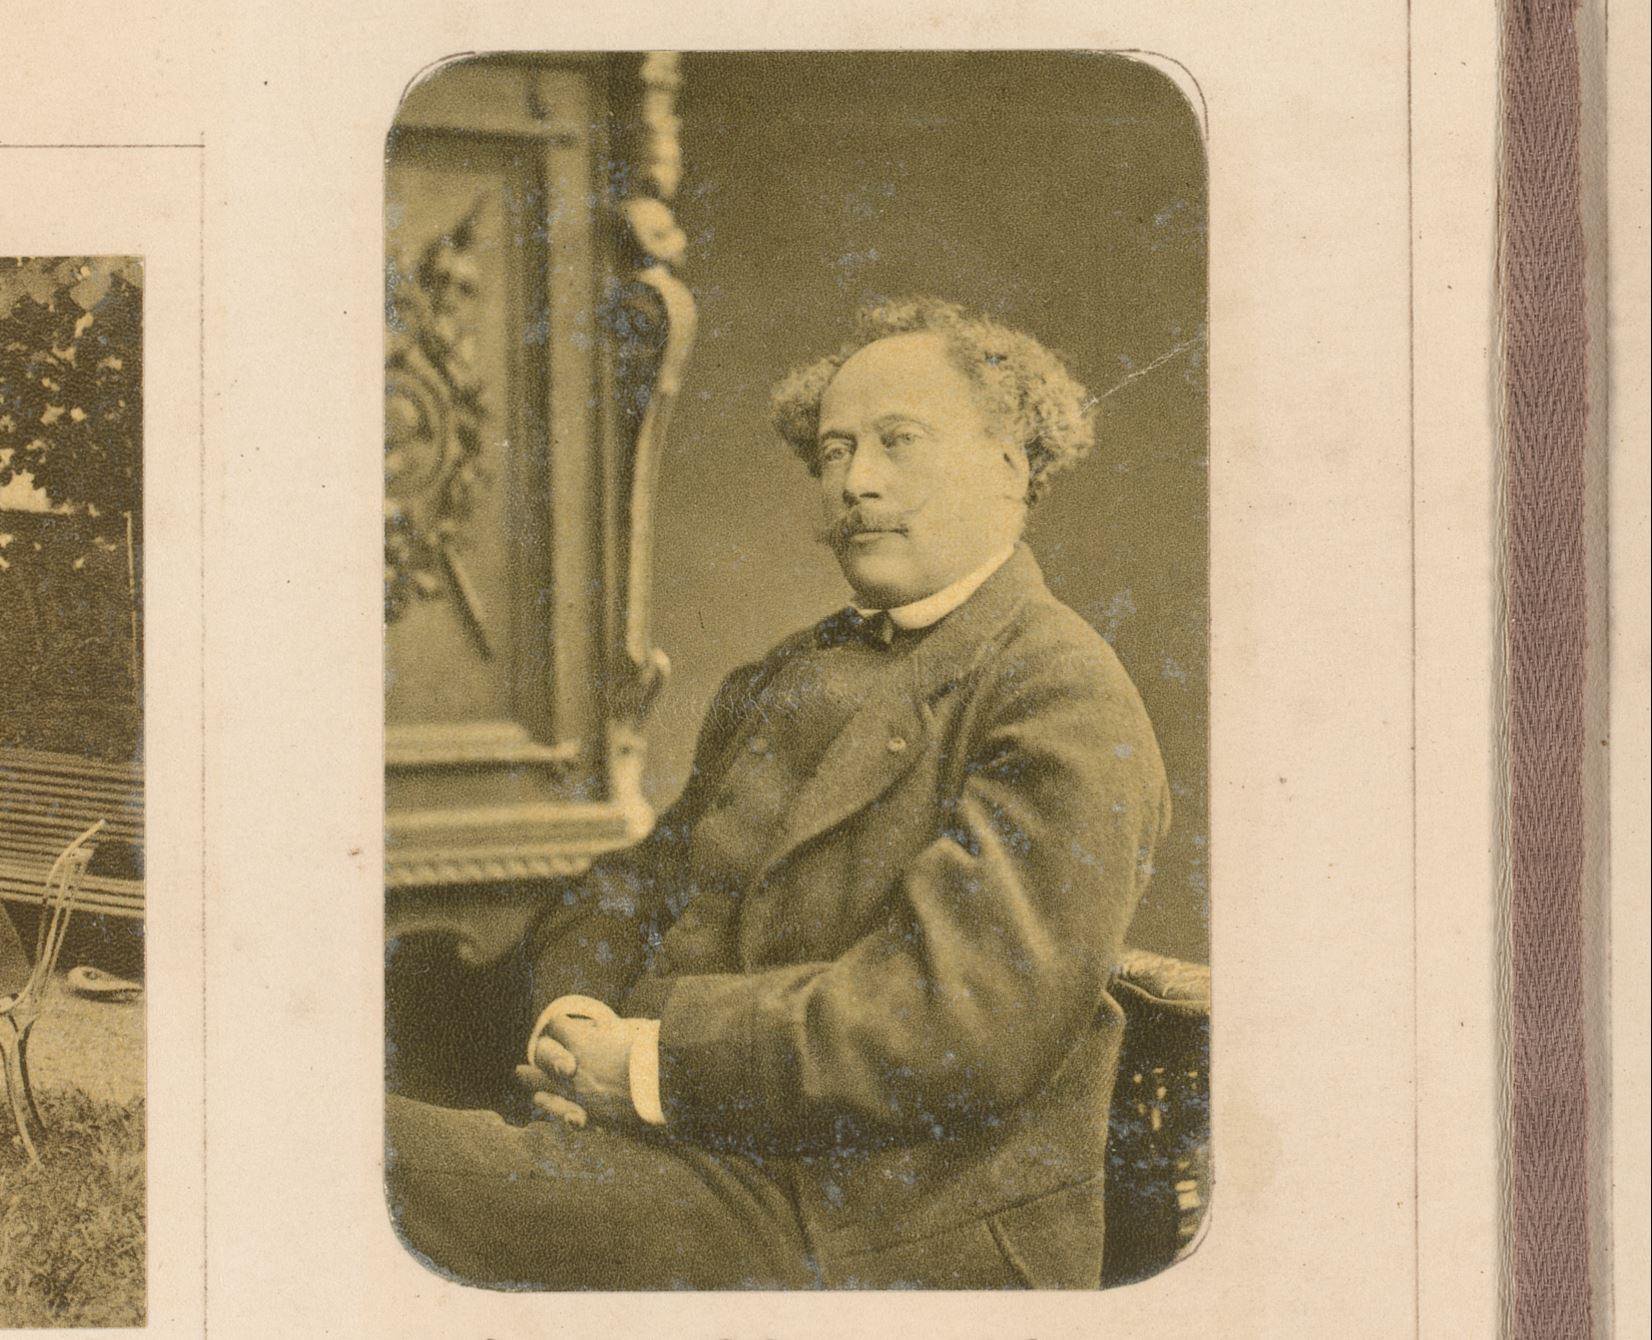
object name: photograph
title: Portret van Alexandre Dumas fils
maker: Anonymous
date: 1884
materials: paper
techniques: rotogravure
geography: france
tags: writer, poet, author, france